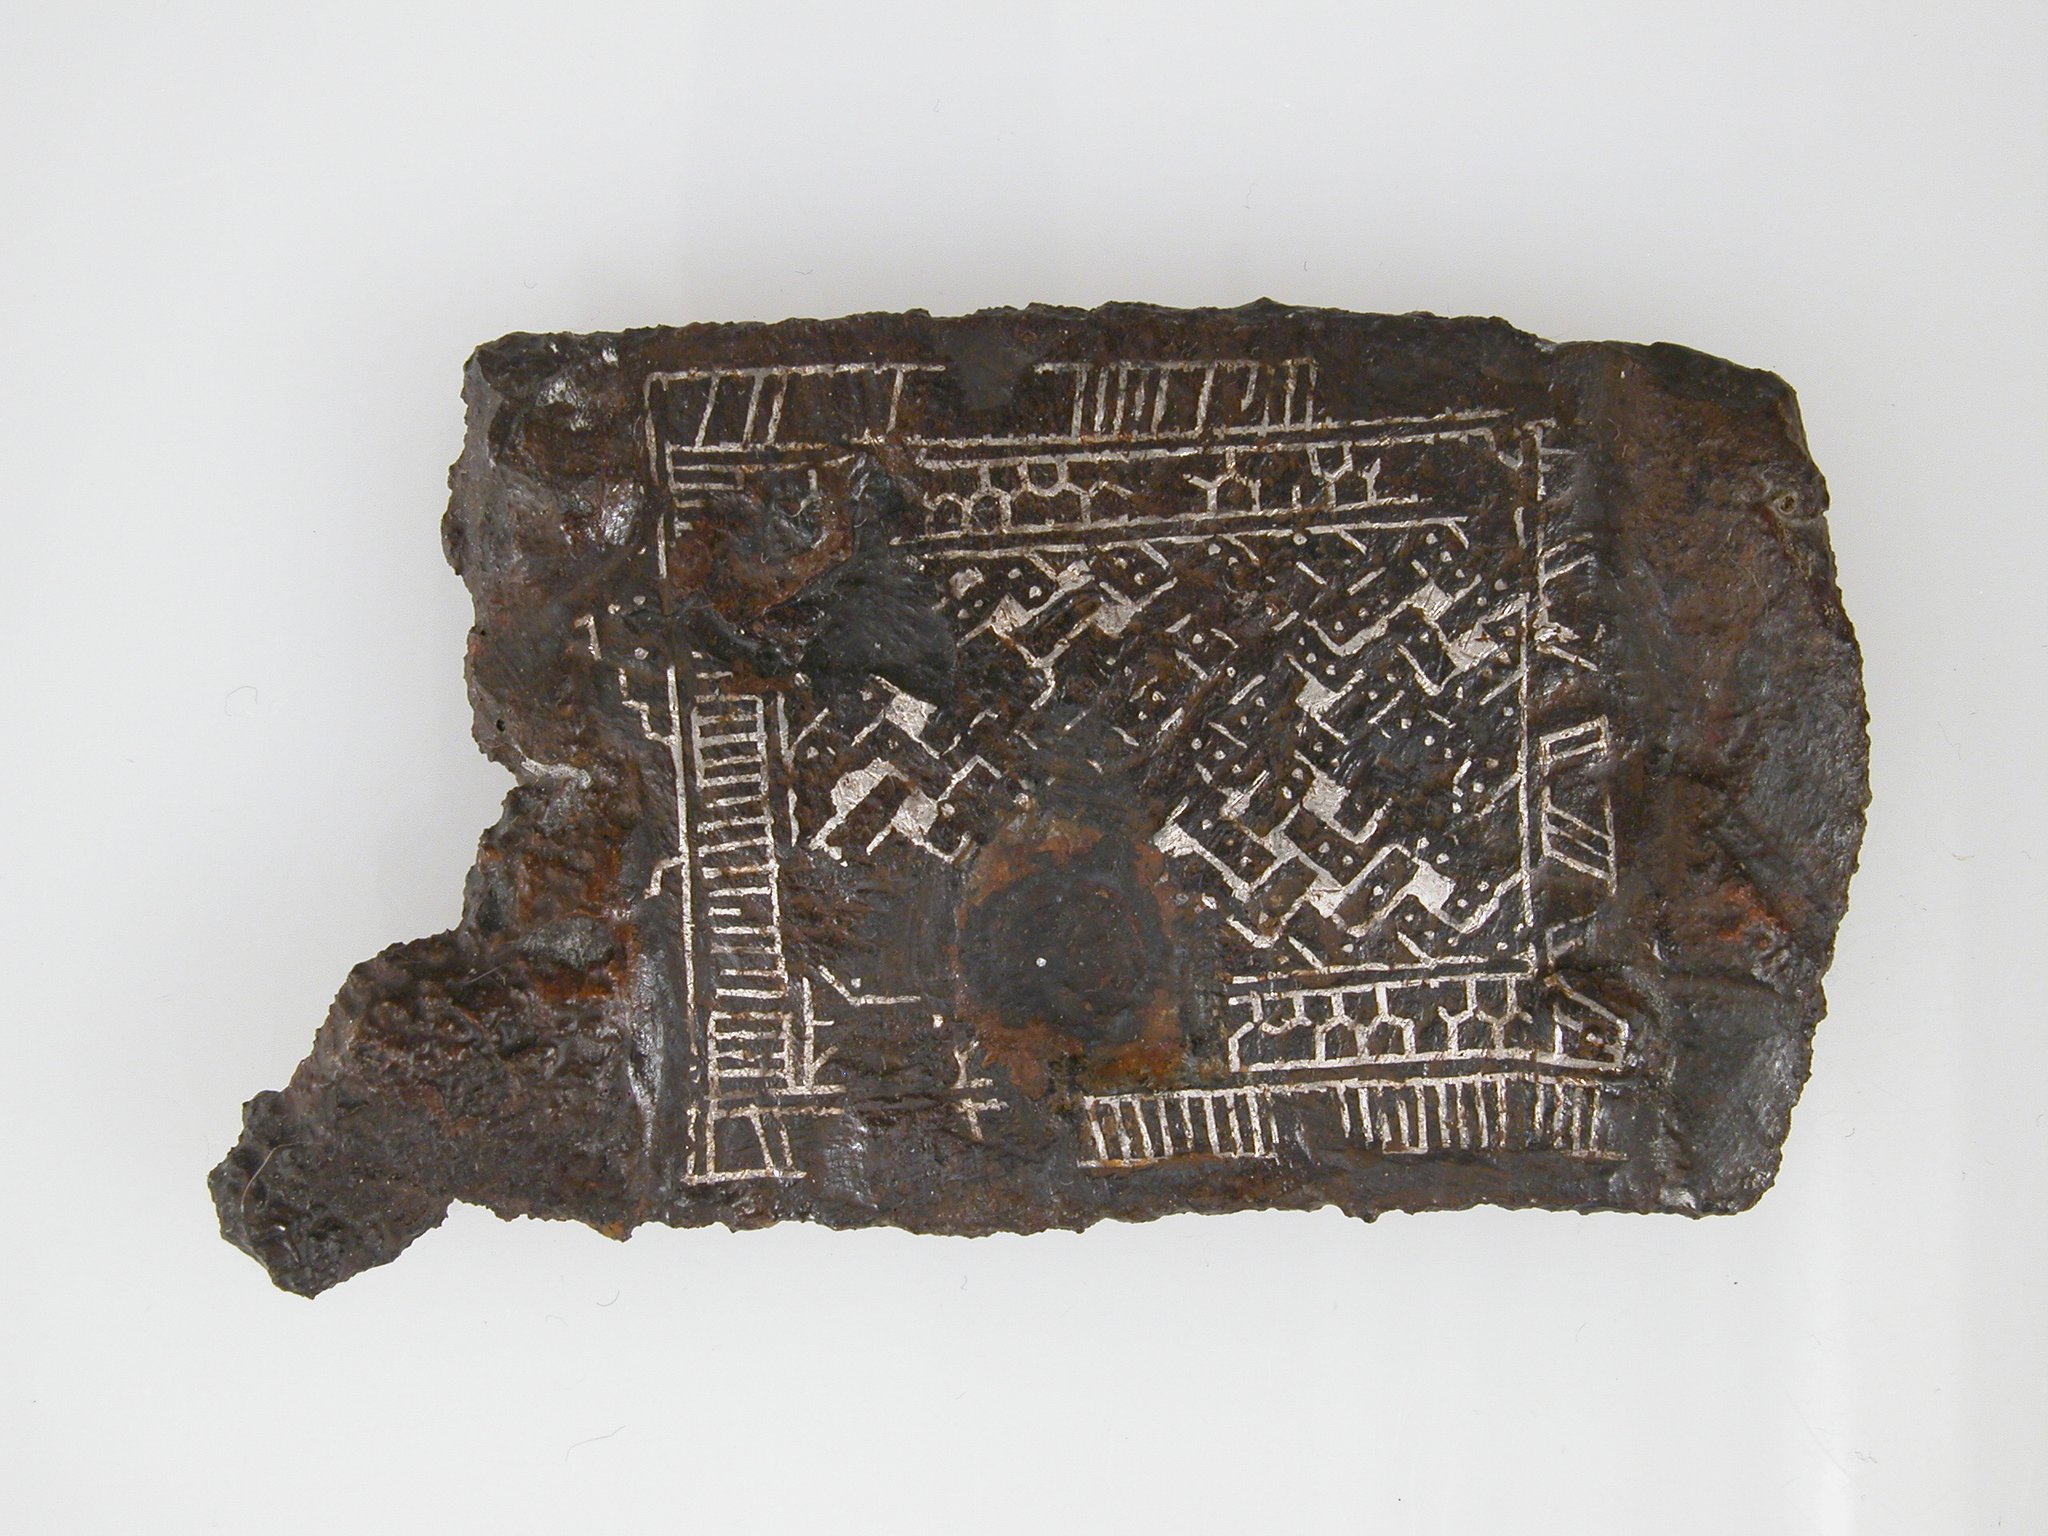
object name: belt plate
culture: frankish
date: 301-700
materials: iron, silver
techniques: inlay